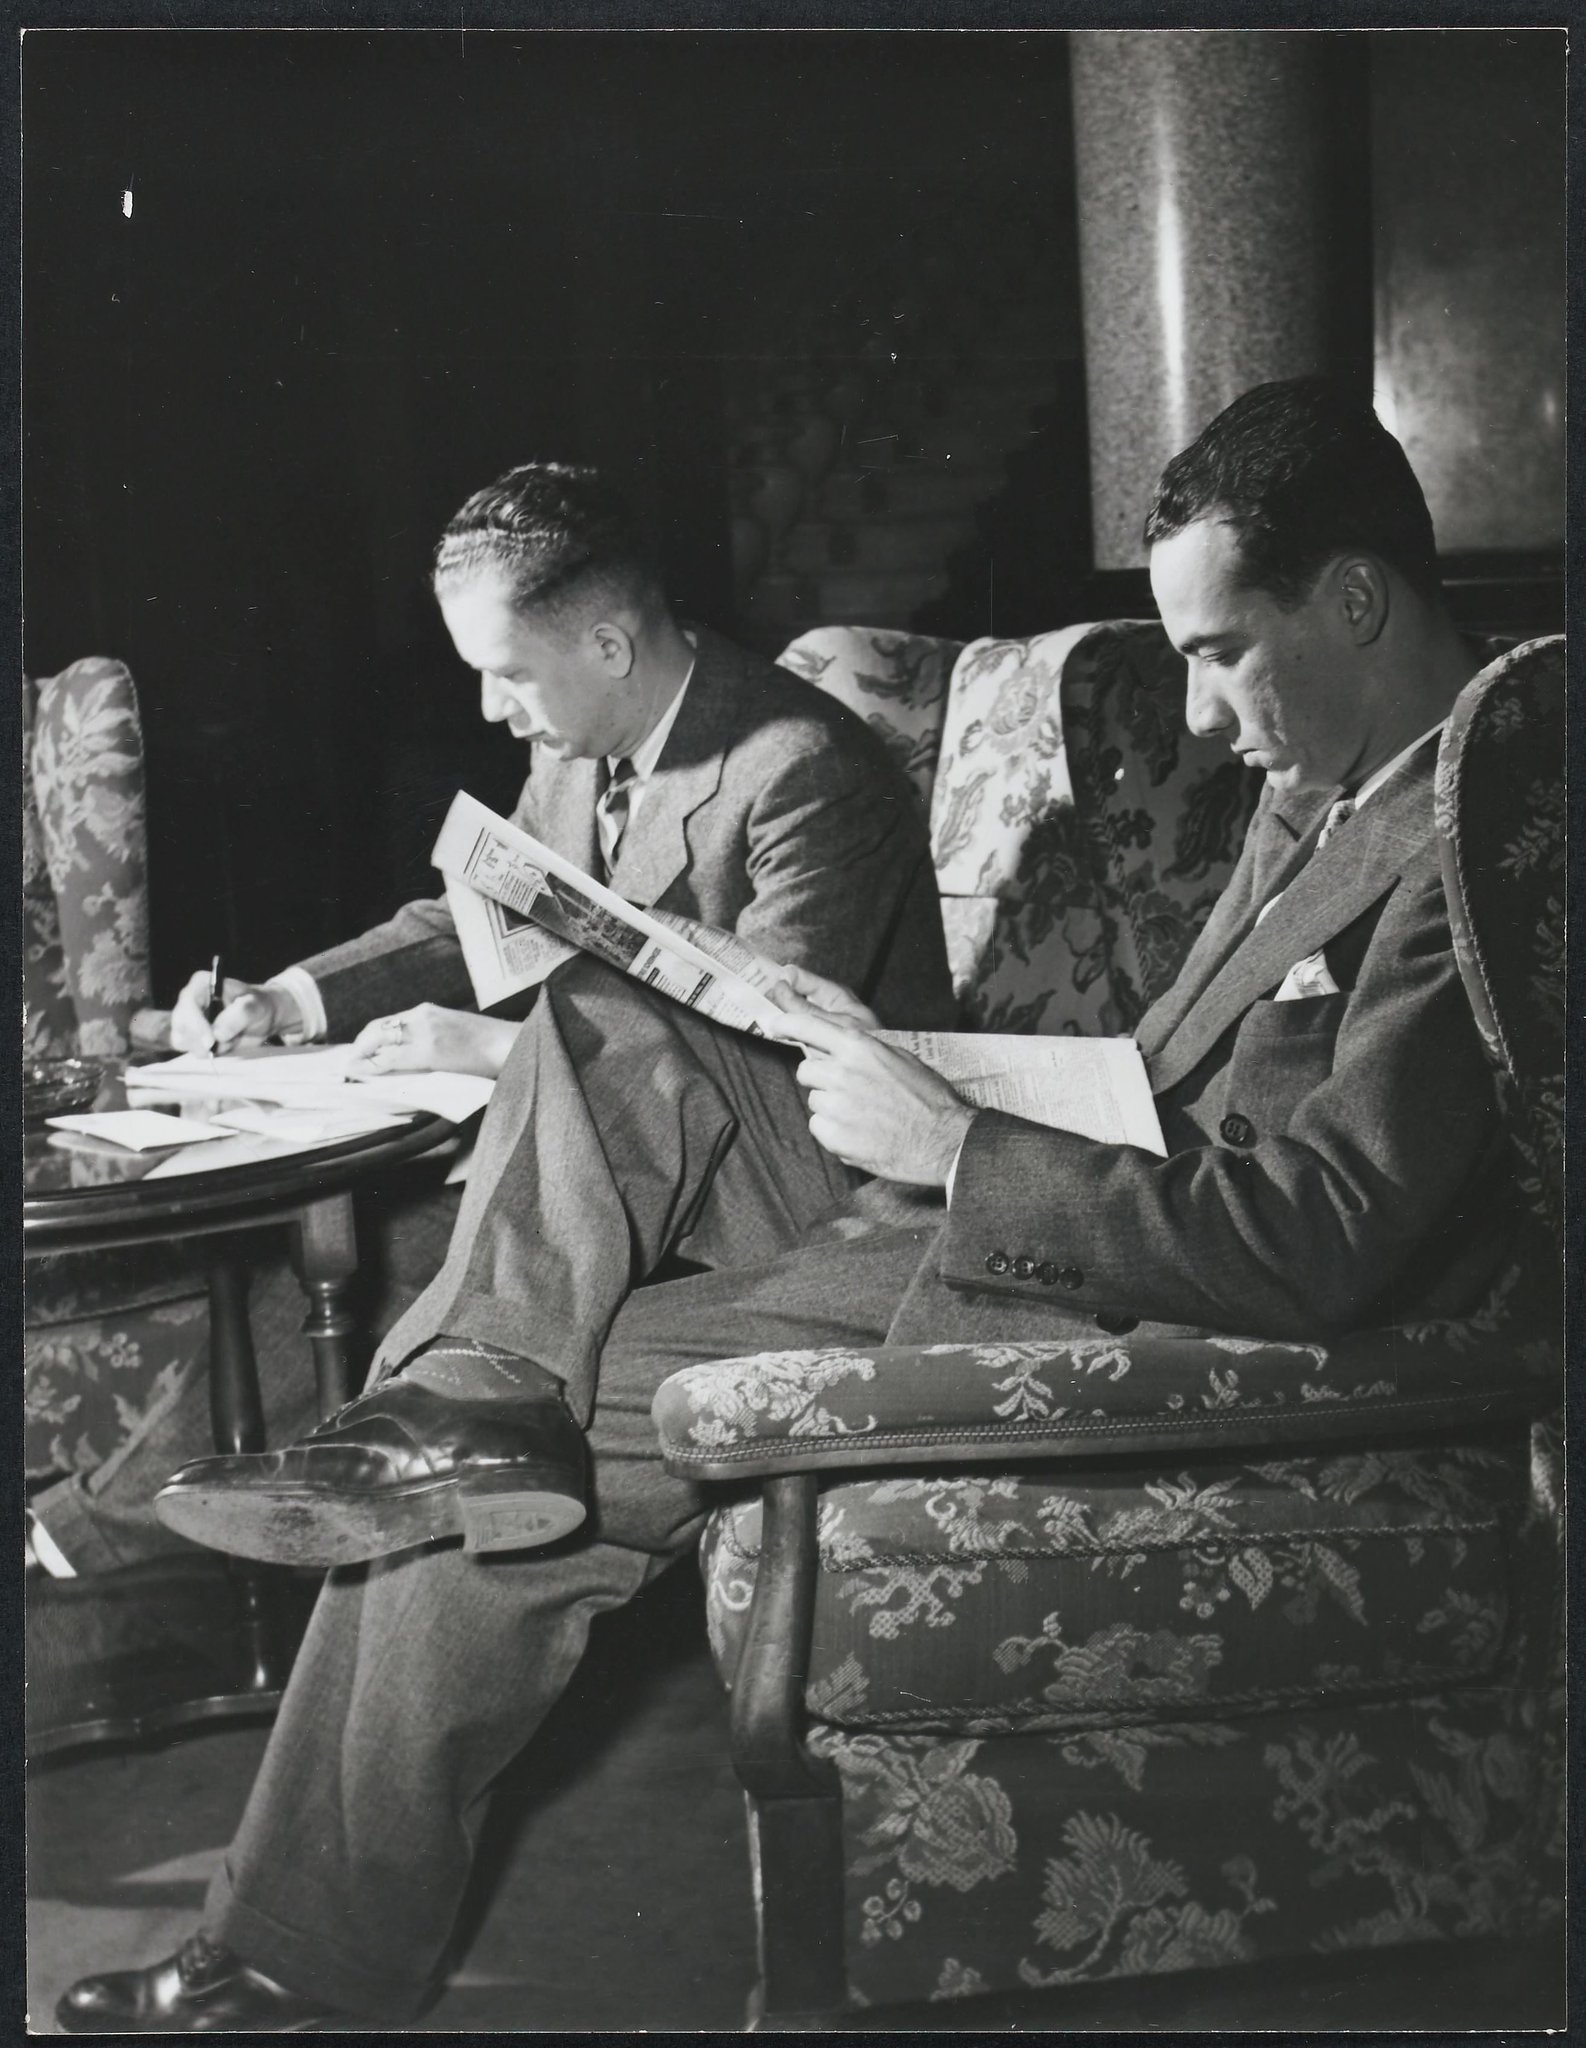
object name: documentary photograph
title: Twee van de deelnemers aan de RTC: Percy Wijngaarde en P.G.A. Findlay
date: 1902-1948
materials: photographic support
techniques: photography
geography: the hague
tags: netherlands, suriname, the hague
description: Een van de deelnemers namens Suriname aan de Ronde Tafel Conferentie tussen Nederland en de West: de journalist Percy Wijngaarde, lid van de Surinaamse staten, bestuurslid van de Nationale Partij en redacteur van "Dagblad Suriname". Naast hem zit de heer P.G.A. Findlay.